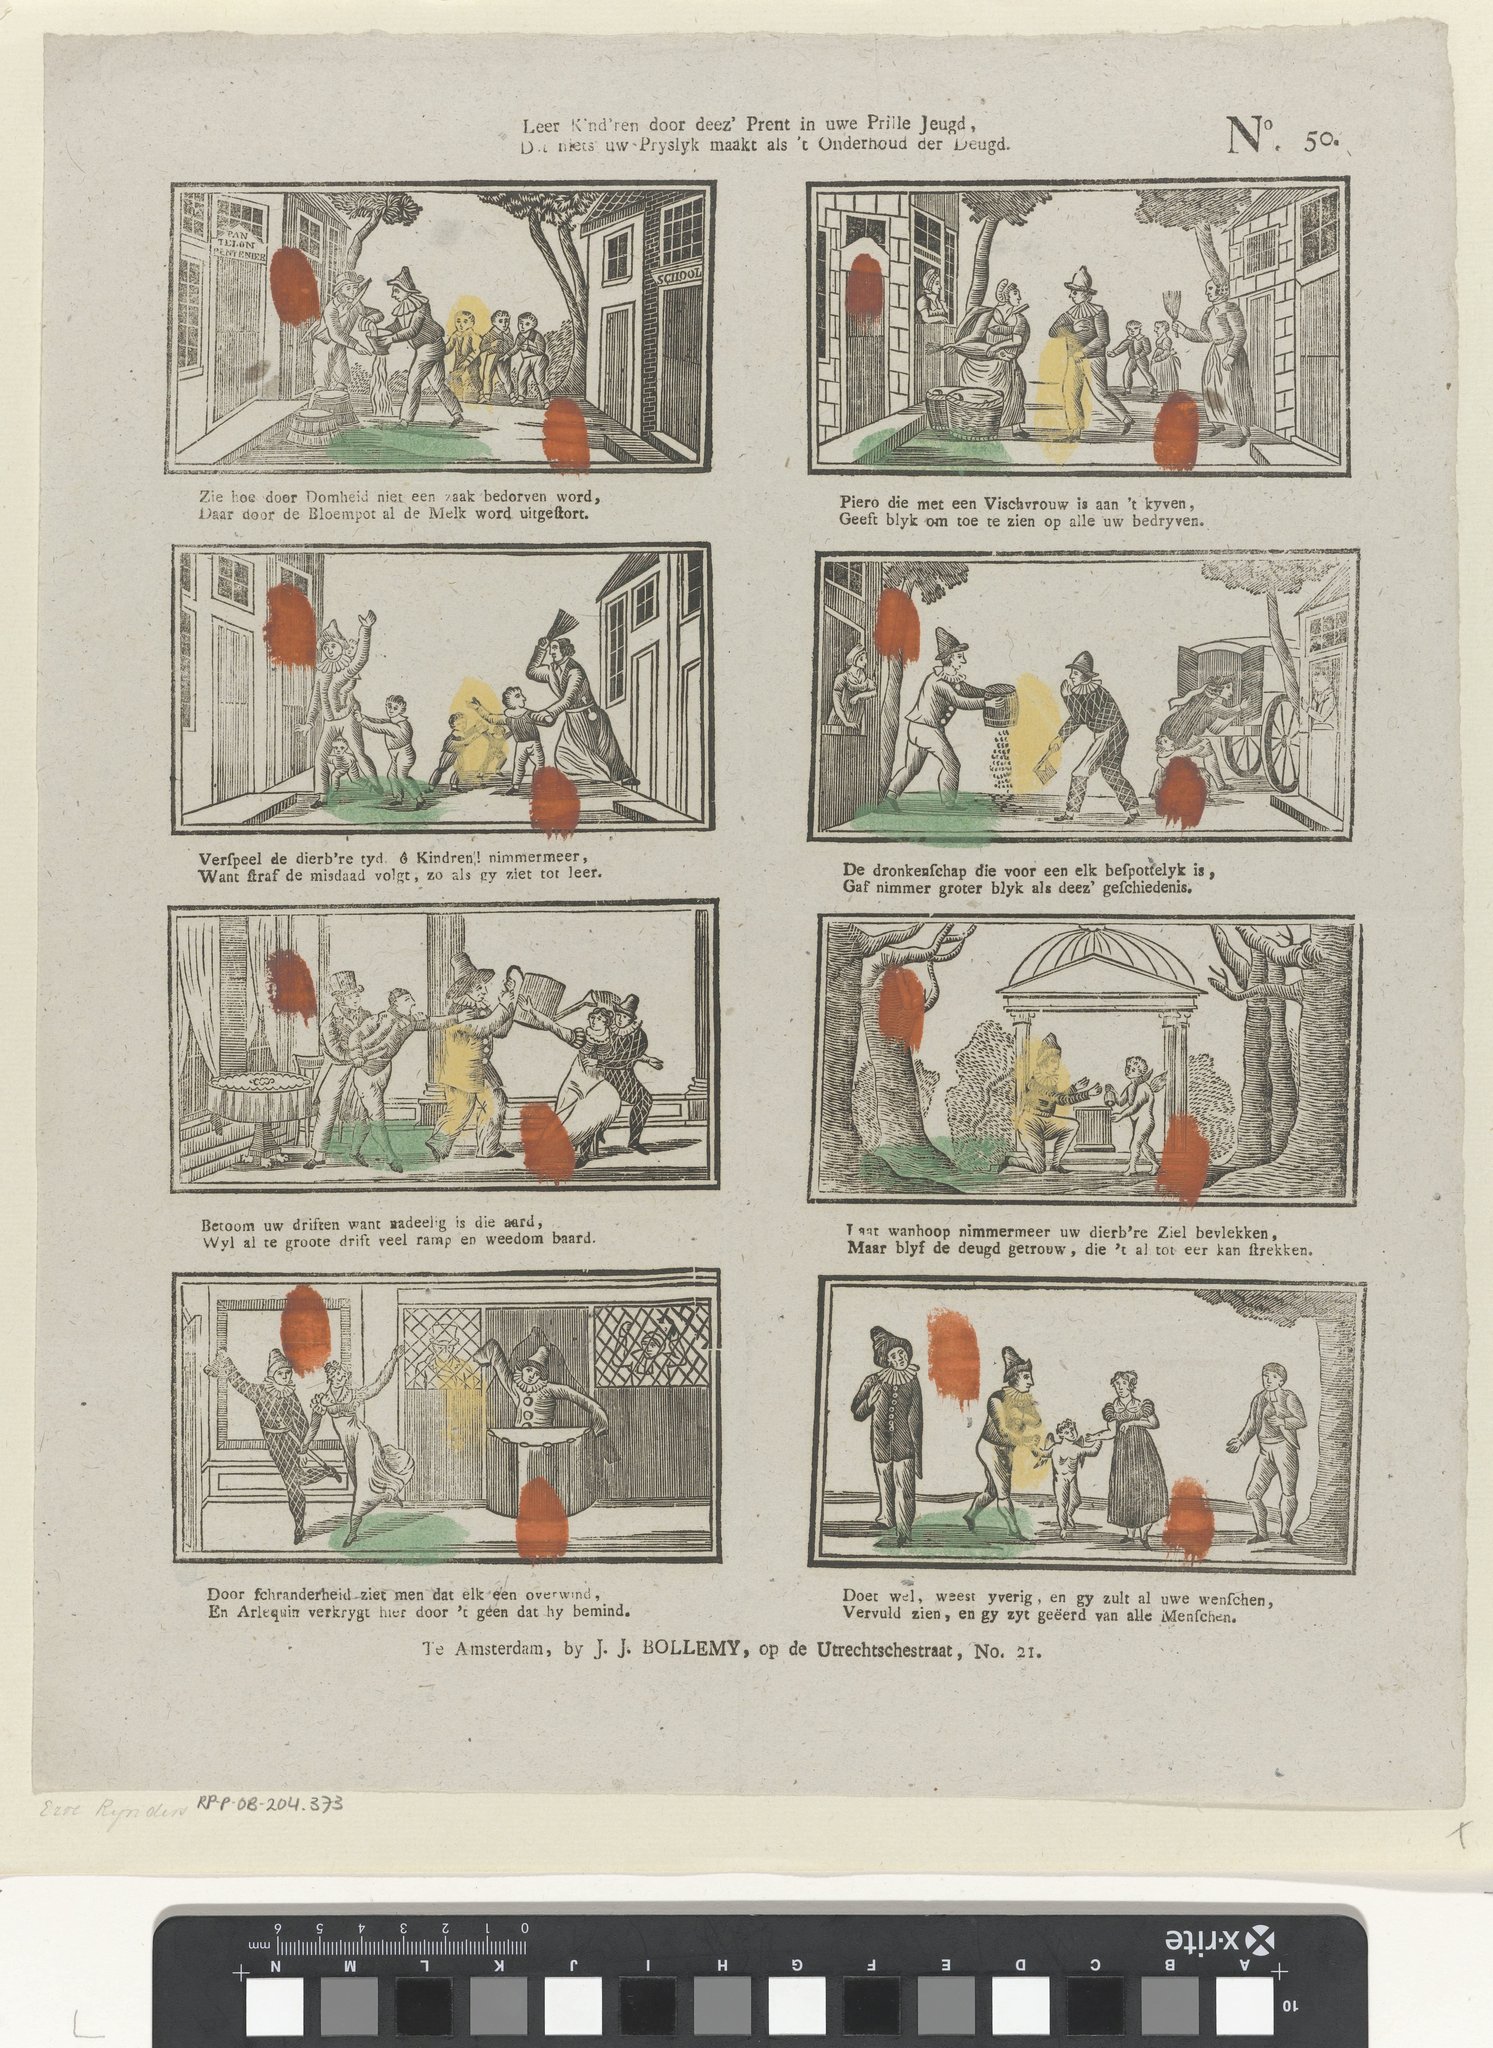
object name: popular print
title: Leer kind'ren door deez' prent in uwe prille jeugd, / Dat niets uw pryslyk maakt als 't onderhoud der deugd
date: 1795-1819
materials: paper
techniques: colour, letterpress printing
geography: amsterdam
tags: types in 'commedia dell'arte'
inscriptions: collector's mark: Lugt 2760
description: Blad met 8 taferelen met personages uit de Commedia dell'arte. Onder elke afbeelding een tweeregelig vers. Genummerd rechtsboven: No. 50.